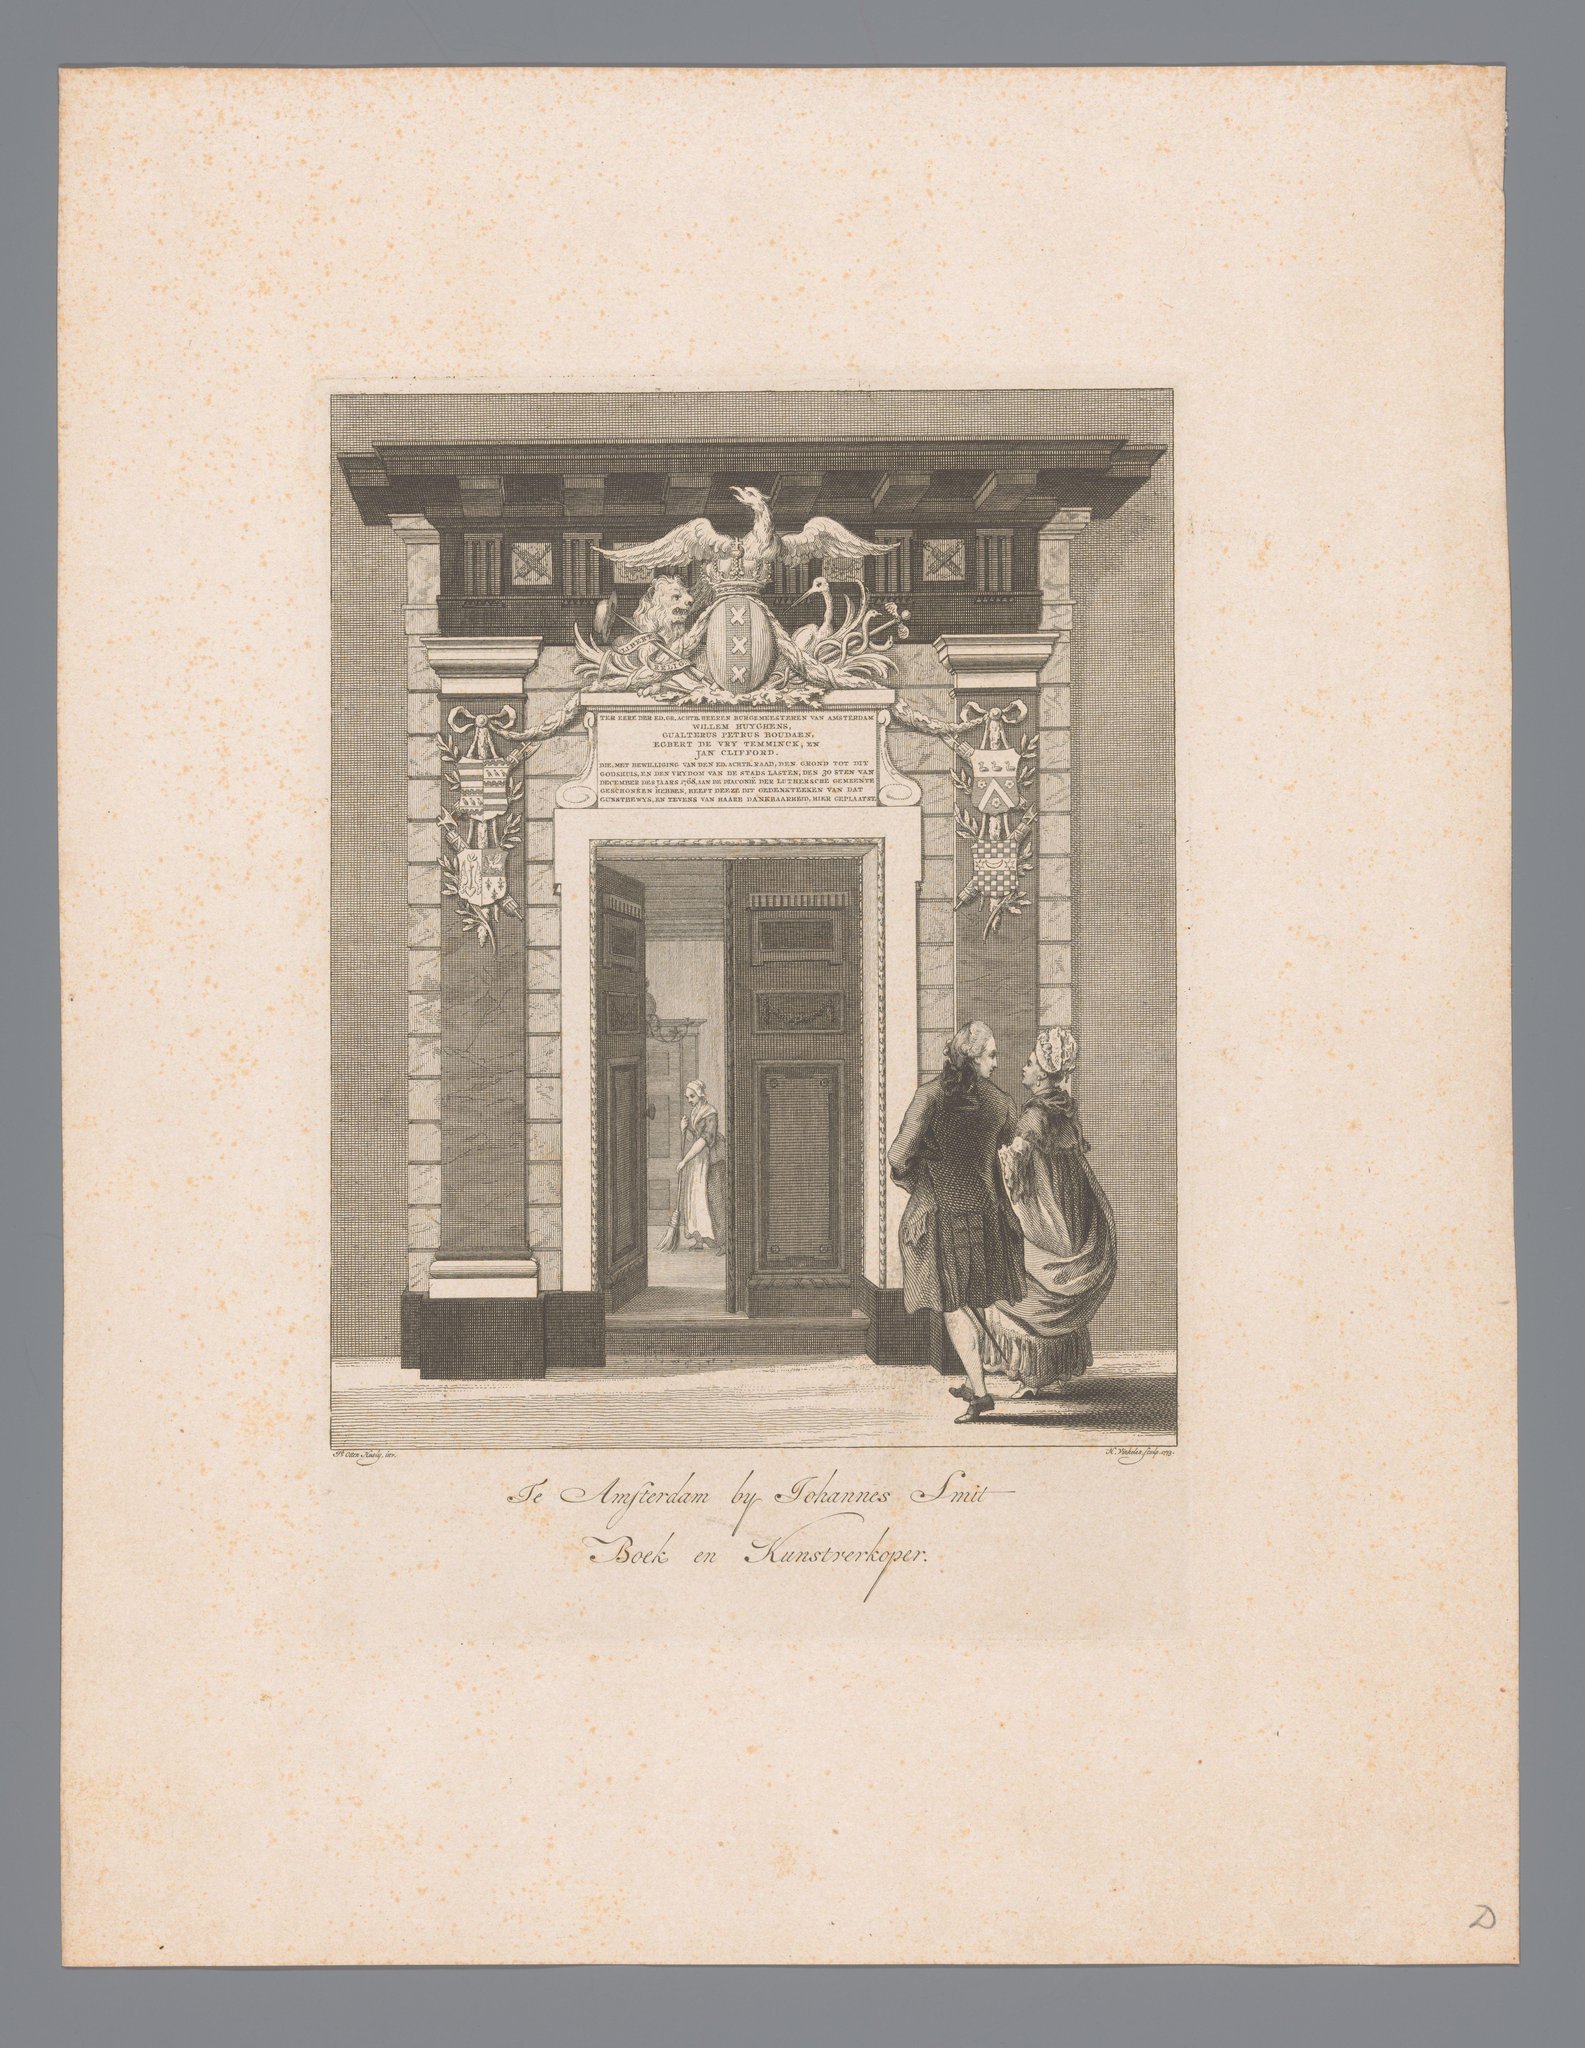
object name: print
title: Poort van het Lutherse Diaconiehuis te Amsterdam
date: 1773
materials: paper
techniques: engraving, etching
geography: amsterdam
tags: gate, entrance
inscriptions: collector's mark: Lugt 2233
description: Poort in de eetzaal van het Lutherse Diaconie Oude Mannen- en Vrouwenhuis.